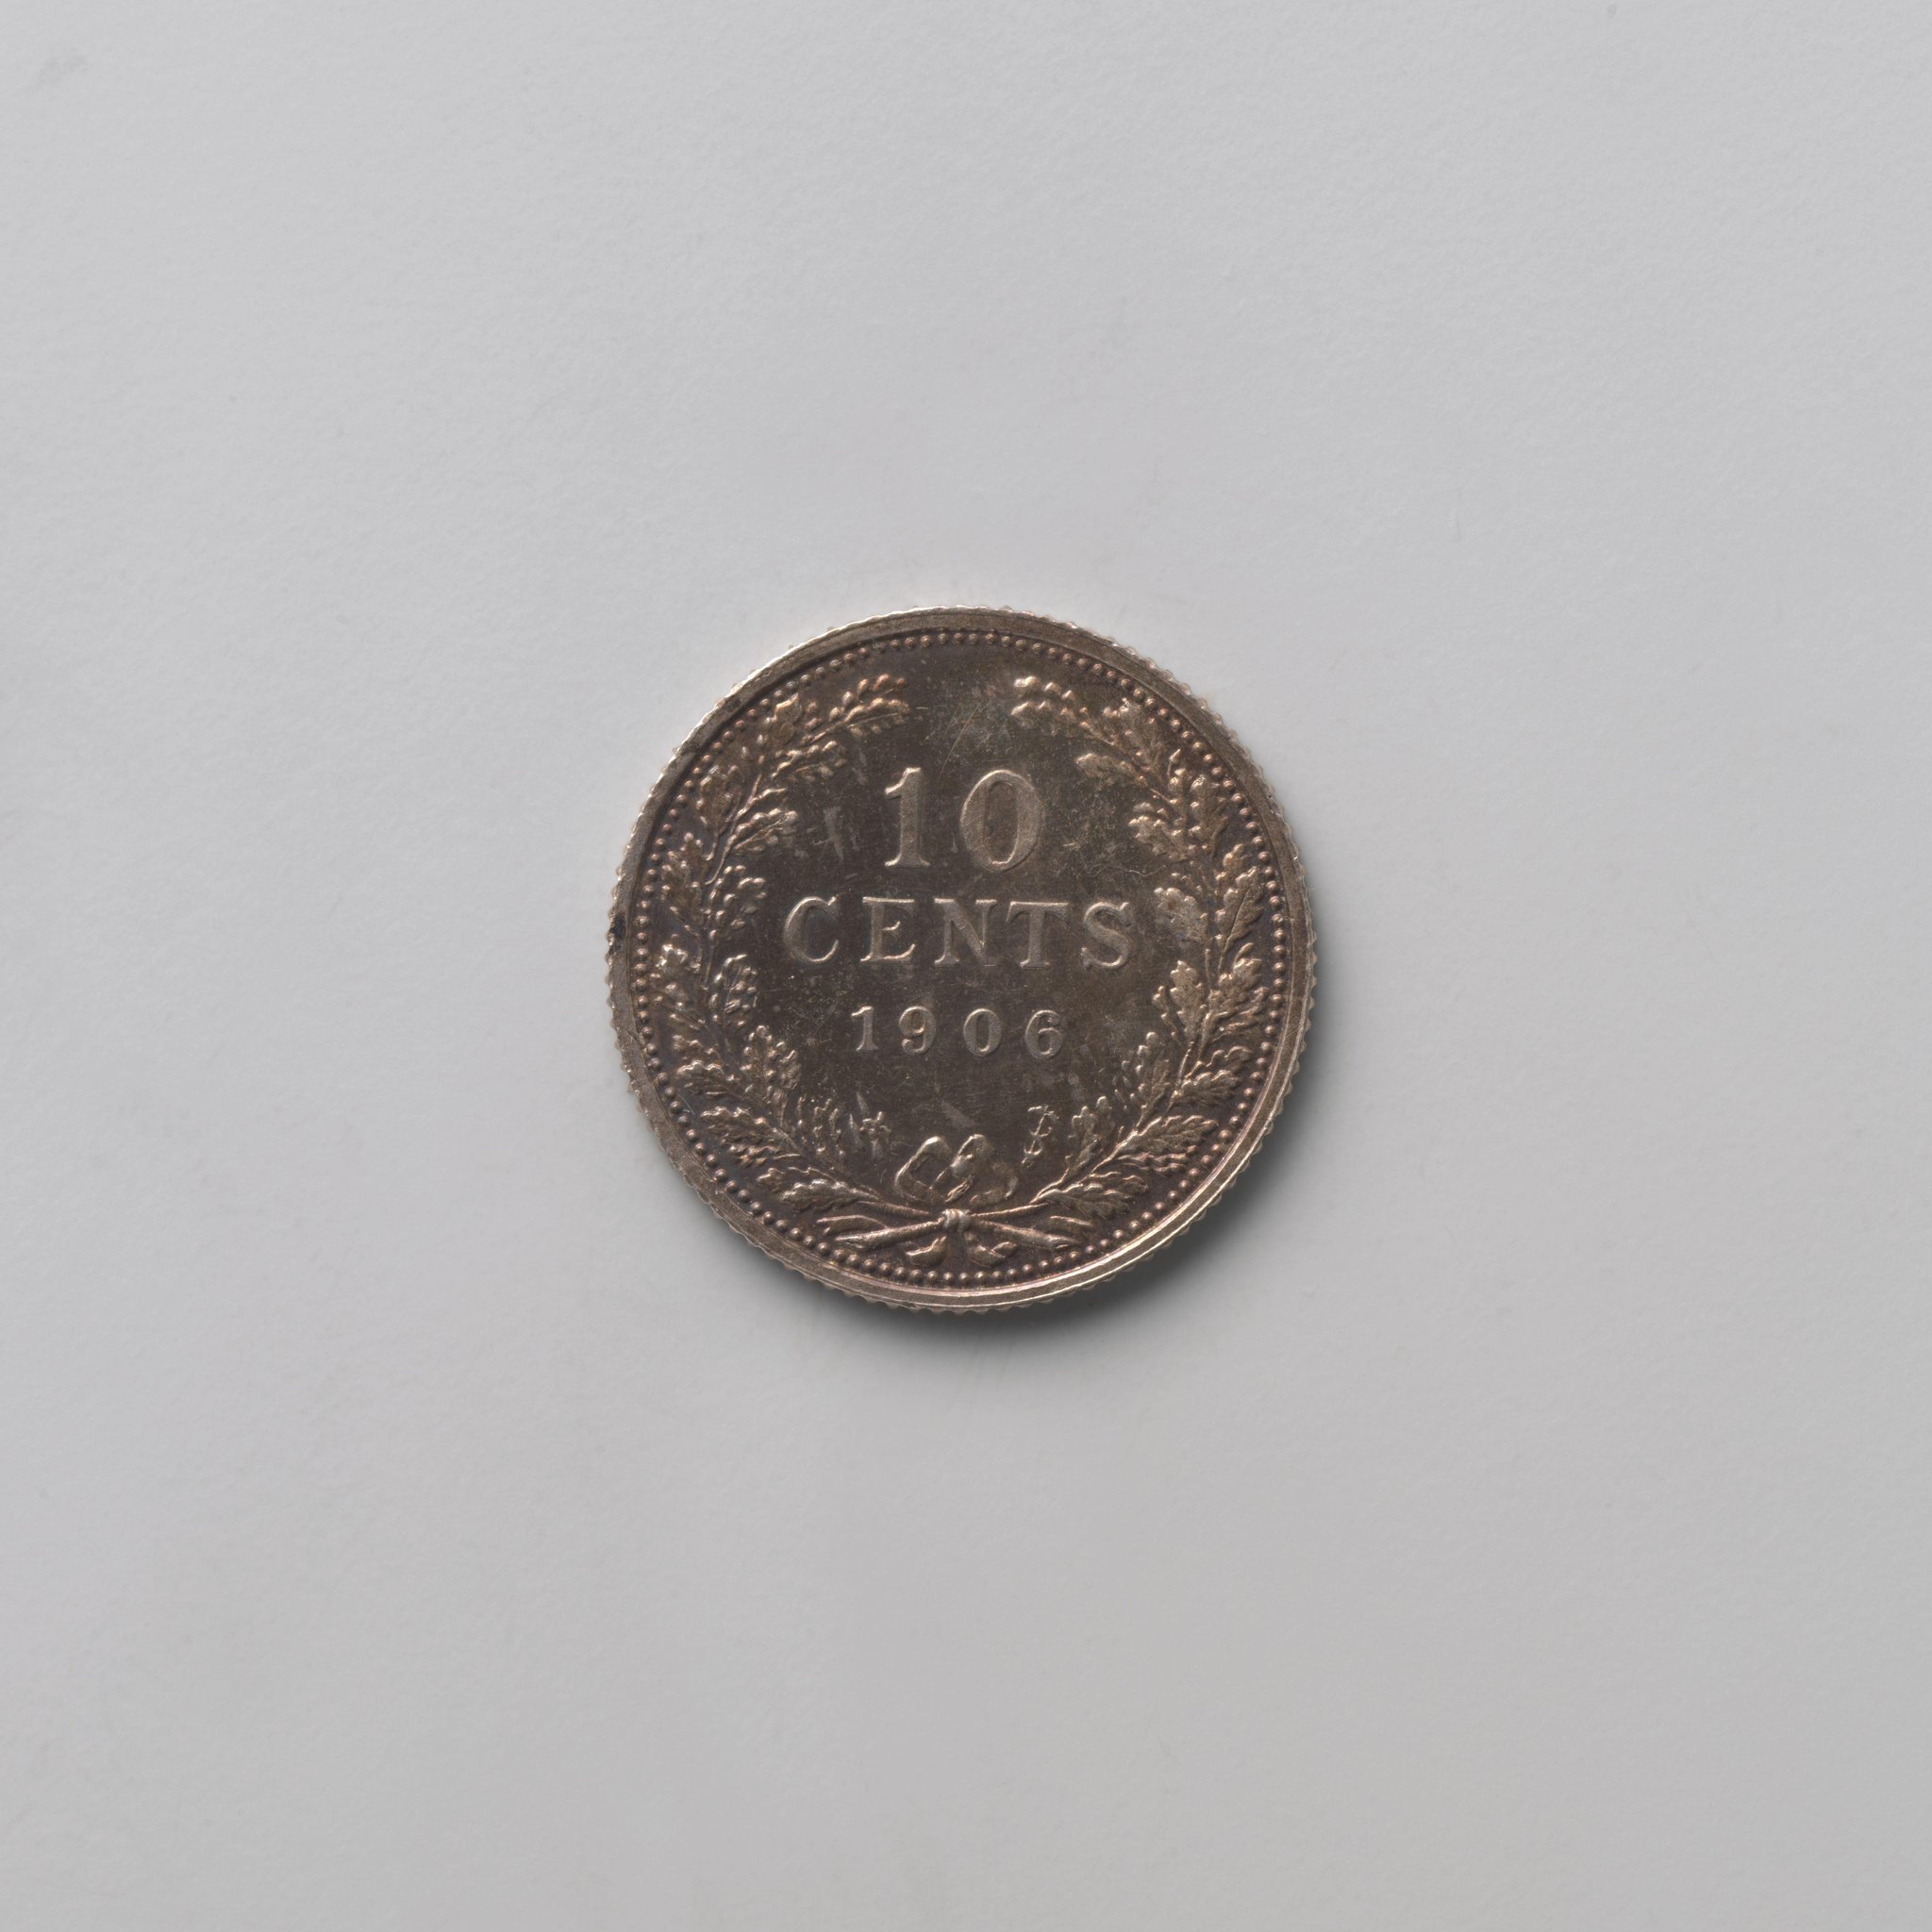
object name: coin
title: Nederlandse10 cent,1906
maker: wilhelmina of the netherlands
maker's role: print maker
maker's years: 1880-1962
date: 1906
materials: silver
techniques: striking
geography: utrecht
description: Zilveren munt. Voorzijde: hoofd met diadeem naar links. Keerzijde: binnen twee samengebonden eiketakken waarde-aanduiding 10 cents en jaartal. Kartelrand.